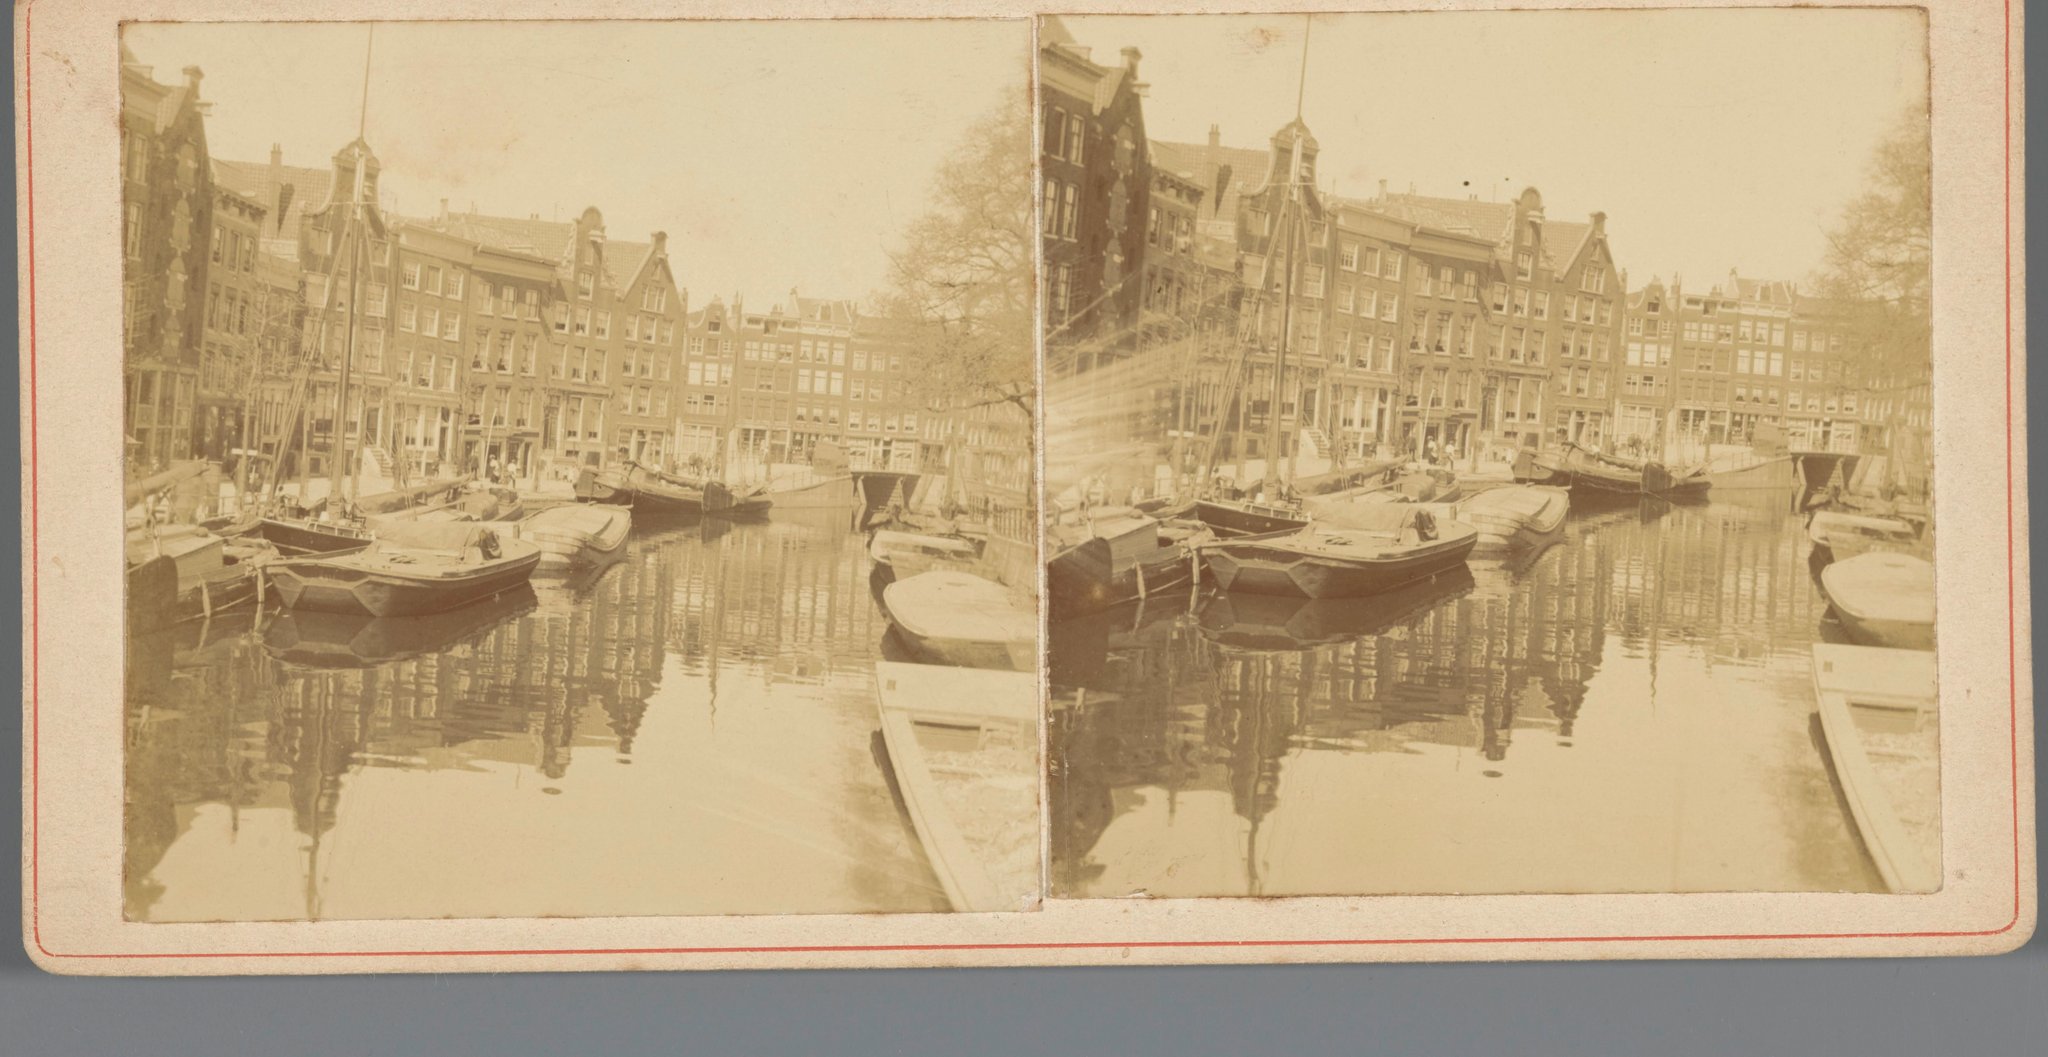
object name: stereograph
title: Prinsengracht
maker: Anonymous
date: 1900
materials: cardboard, photographic support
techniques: gelatin silver print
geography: amsterdam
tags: prinsengracht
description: De Prinsengracht te Amsterdam. Onderdeel van een groep van 5 foto's en 19 stereofoto's gemaakt door een onbekende amateurfotograaf rond 1900 in Amsterdam, de Ardennen en Denemarken.